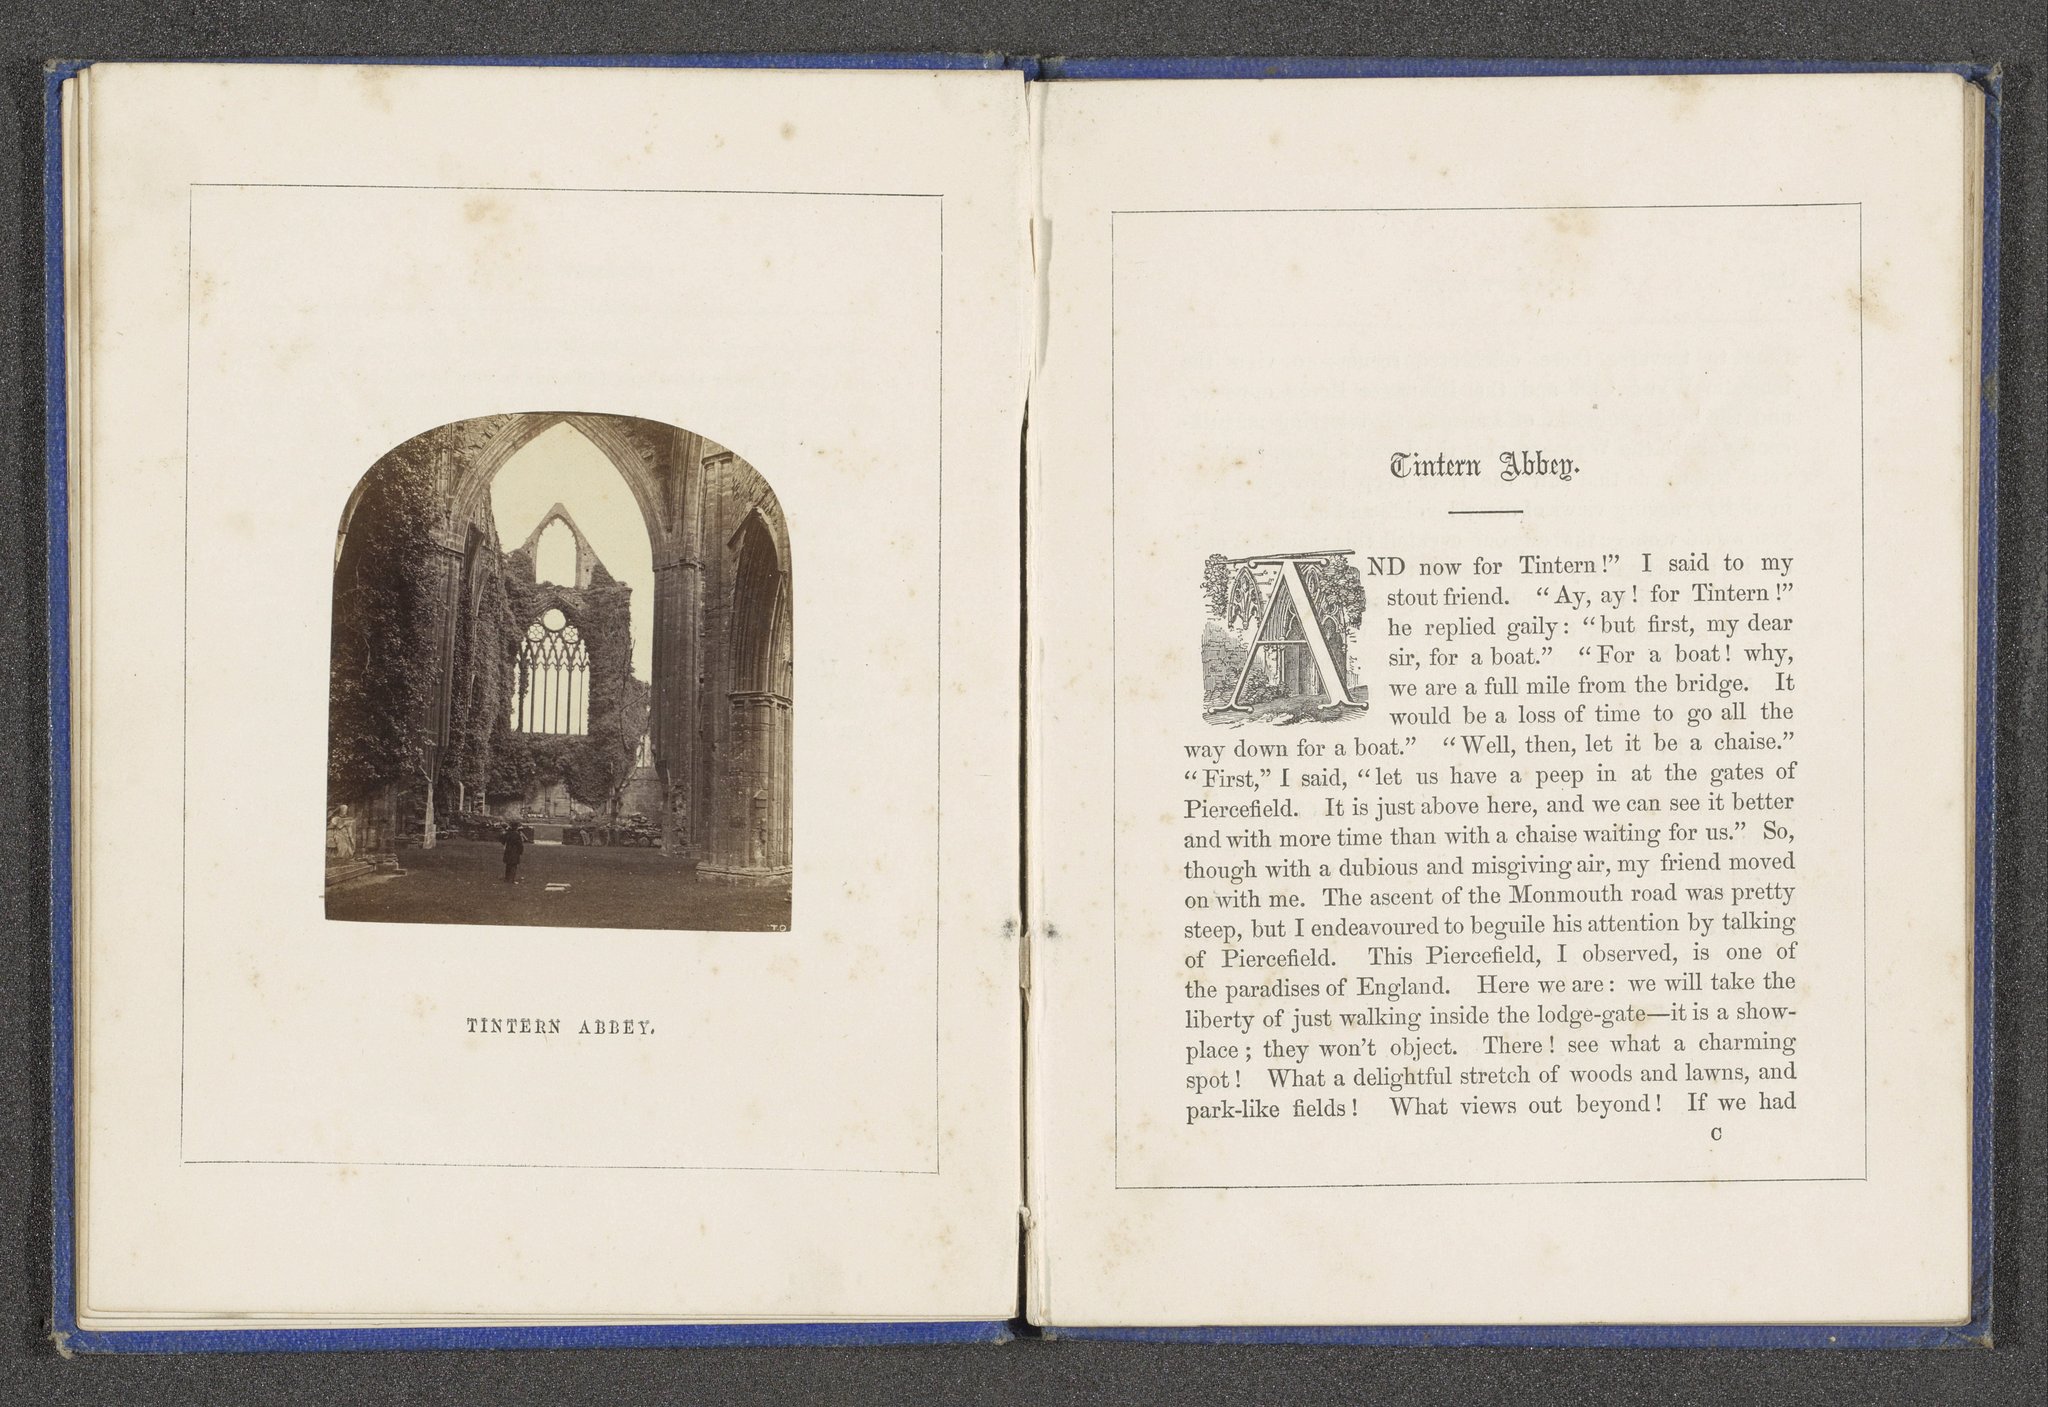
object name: photograph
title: Interieur van de ruïne van Tintern Abbey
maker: william russell sedgfield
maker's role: fotograaf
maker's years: 1826-1902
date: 1853-1863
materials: photographic support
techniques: albumen print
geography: tintern abbey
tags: ruin of church, monastery, etc.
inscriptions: inscription: ‘T.O’